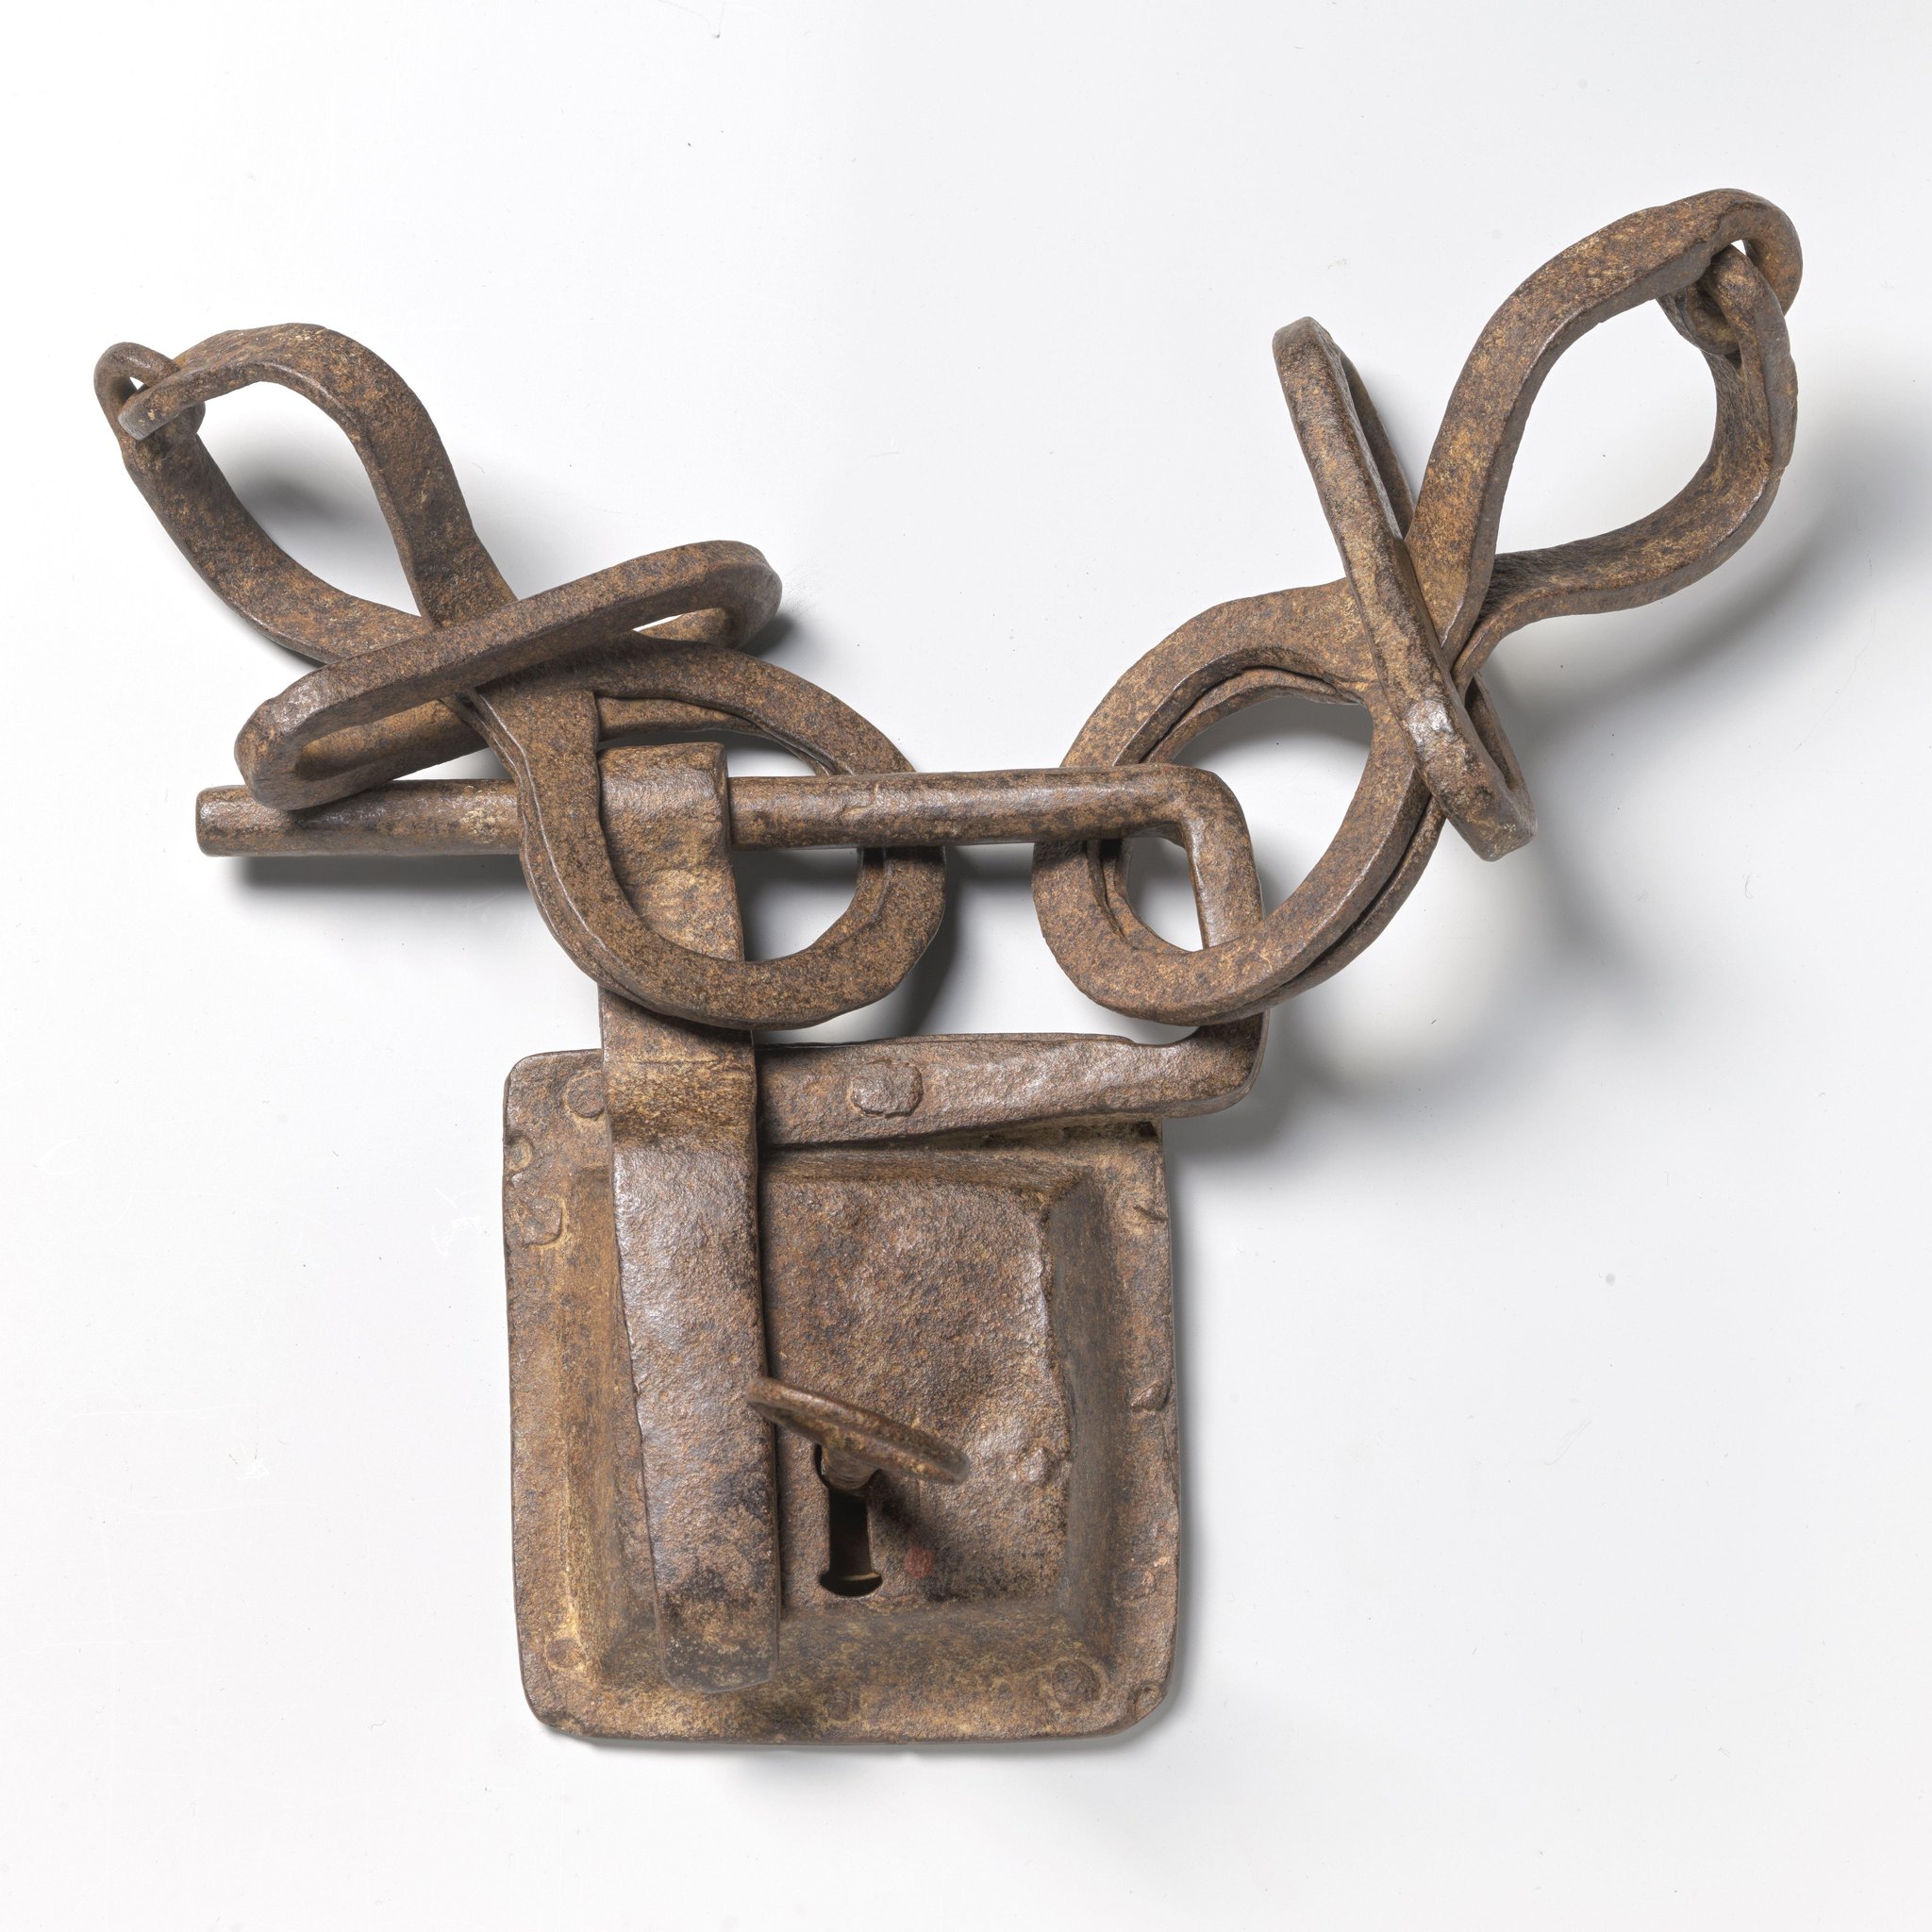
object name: voetboeien, kluister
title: Enkelboei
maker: Anonymous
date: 1600-1800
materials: iron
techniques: forging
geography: netherlands